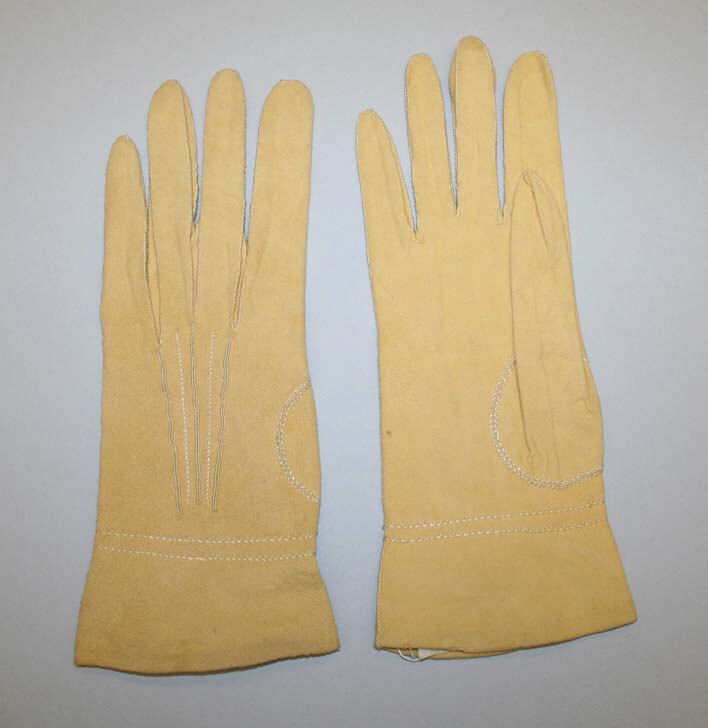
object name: glove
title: Gloves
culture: american or european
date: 1801-1833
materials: leather